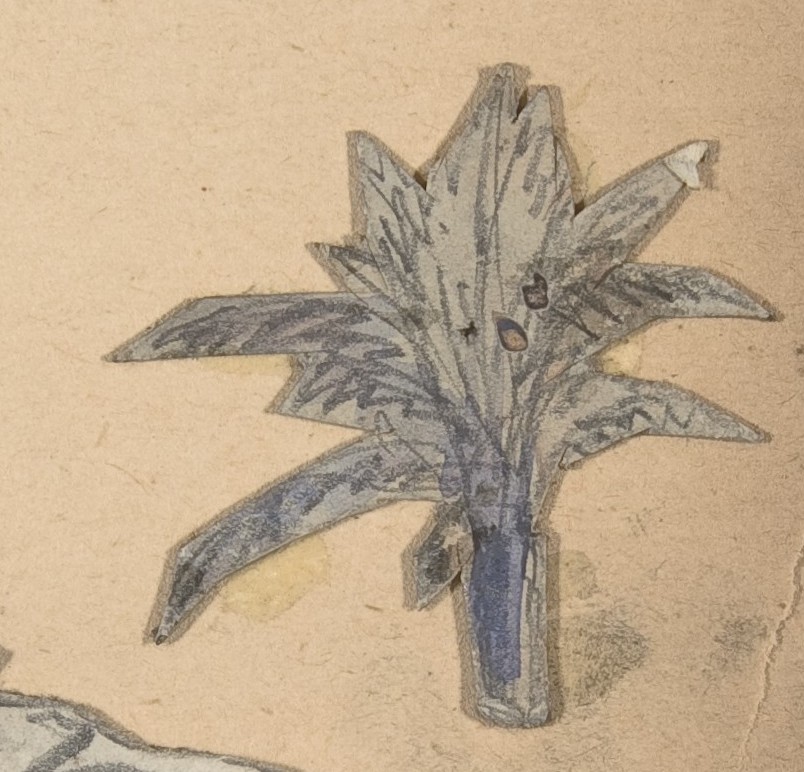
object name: drawing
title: Design for a Stage Set at the Opéra, Paris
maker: eugène cicéri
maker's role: artist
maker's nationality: french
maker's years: 1813-1890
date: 1825-1890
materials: graphite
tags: stage design